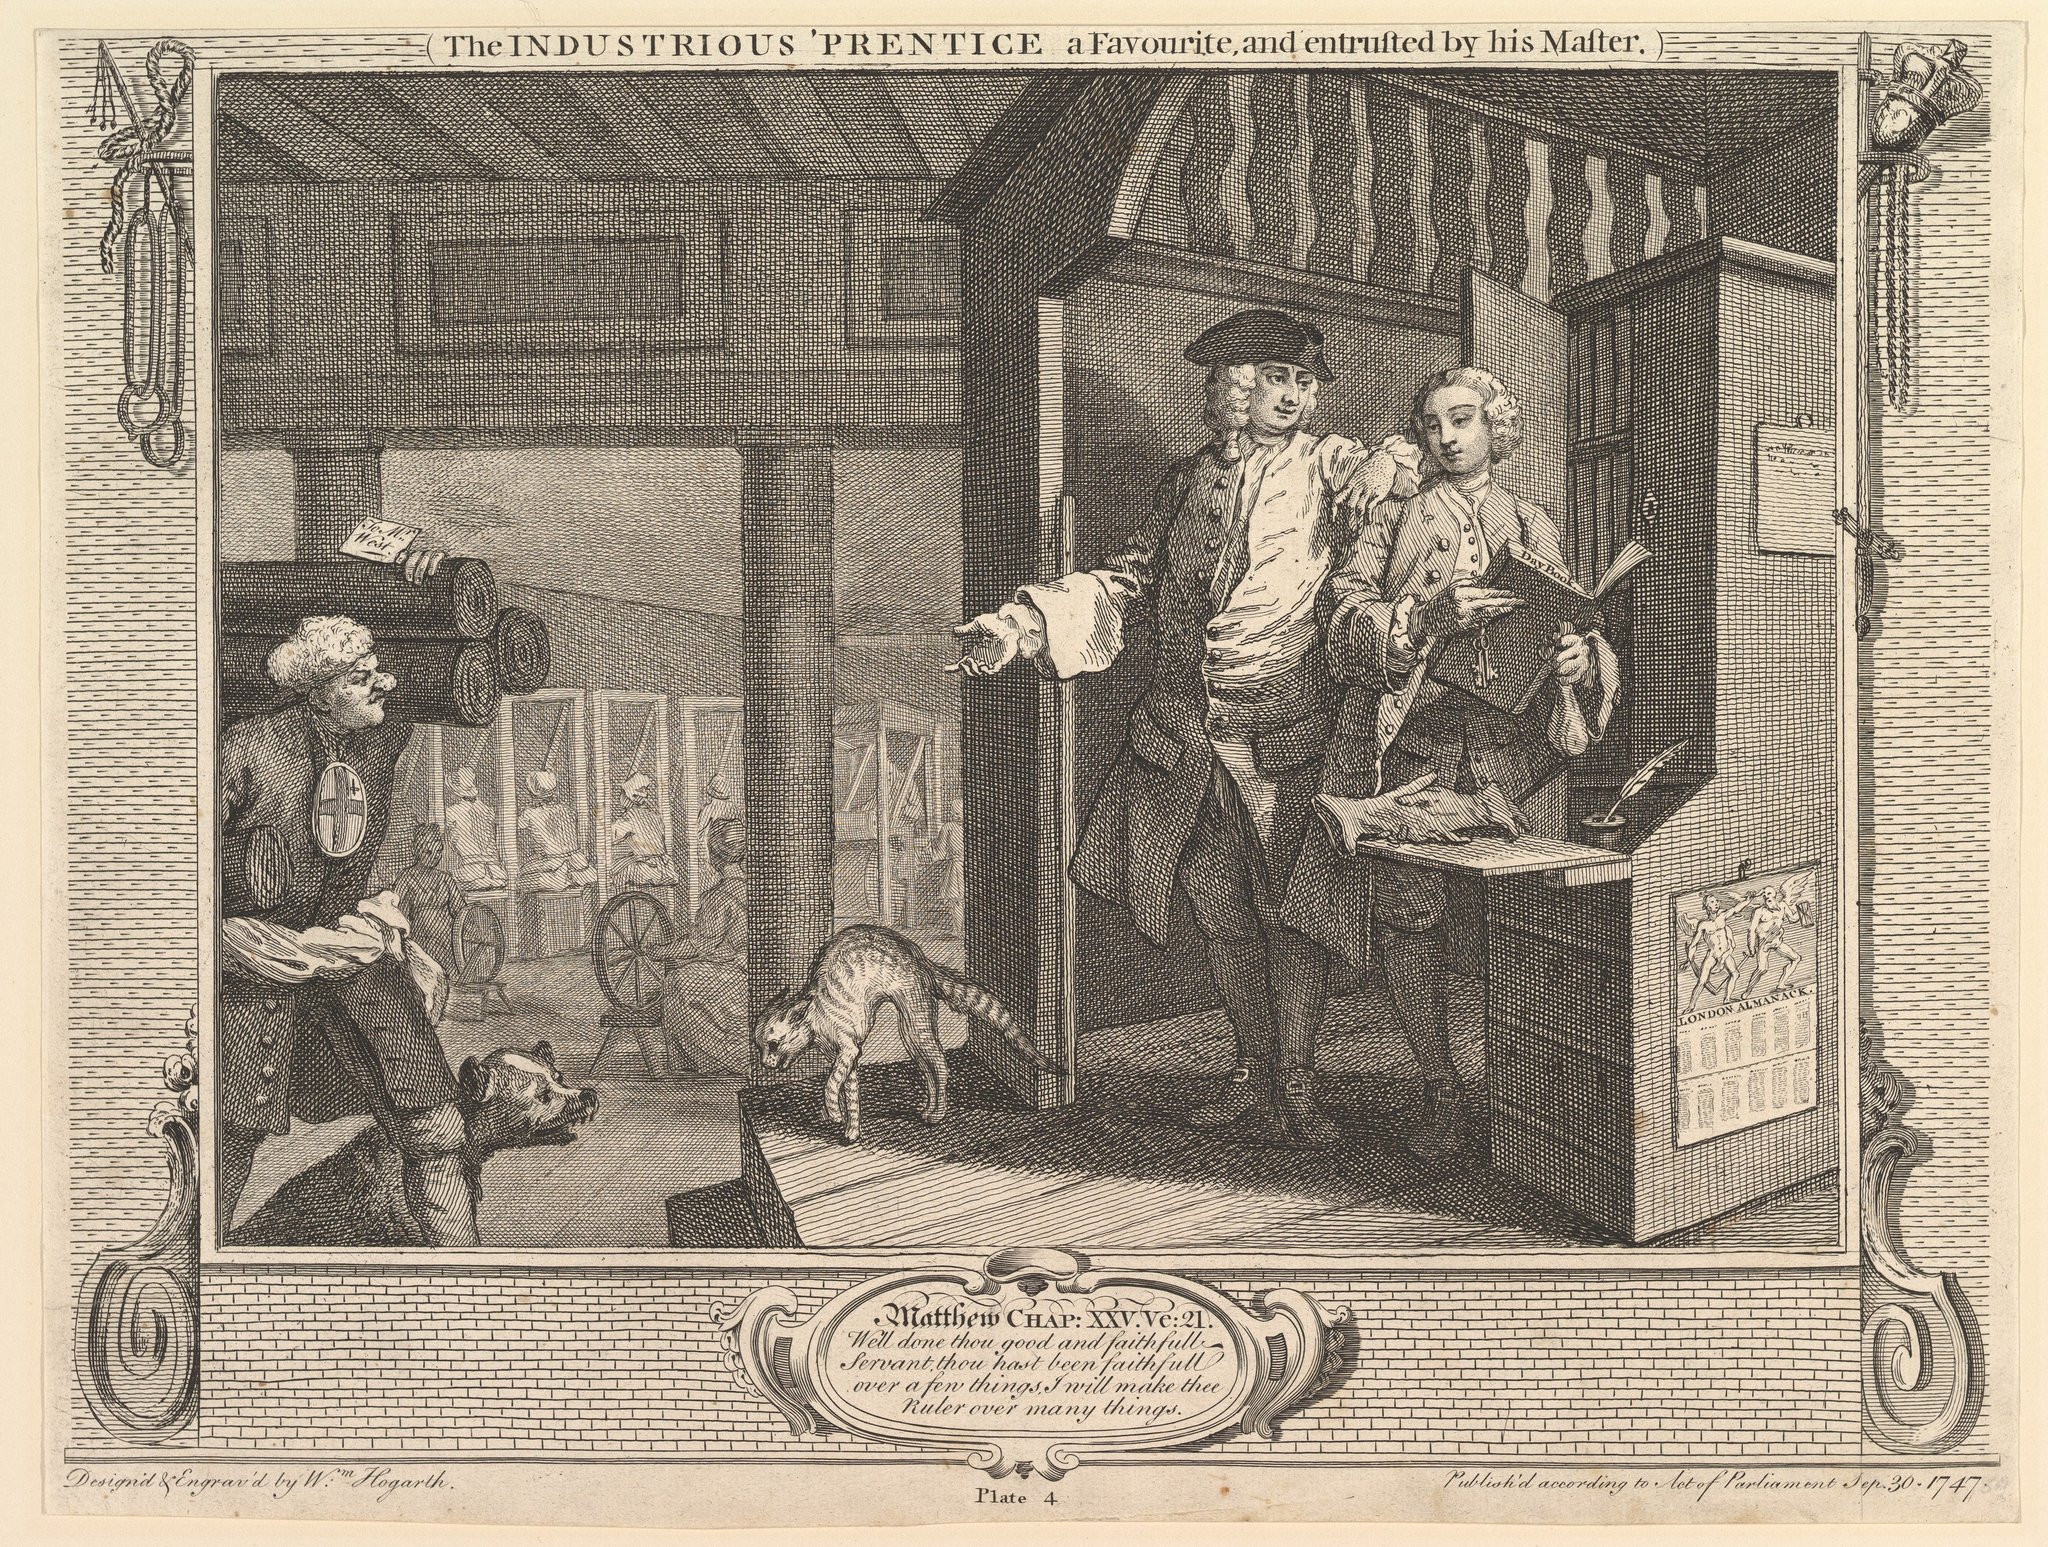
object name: print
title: The Industrious 'Prentice a Favorite, and Entrusted by his Master: Industry and Idleness, plate 4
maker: william hogarth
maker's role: artist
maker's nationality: british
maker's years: 1697-1764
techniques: engraving, etching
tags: animals,men,women,working